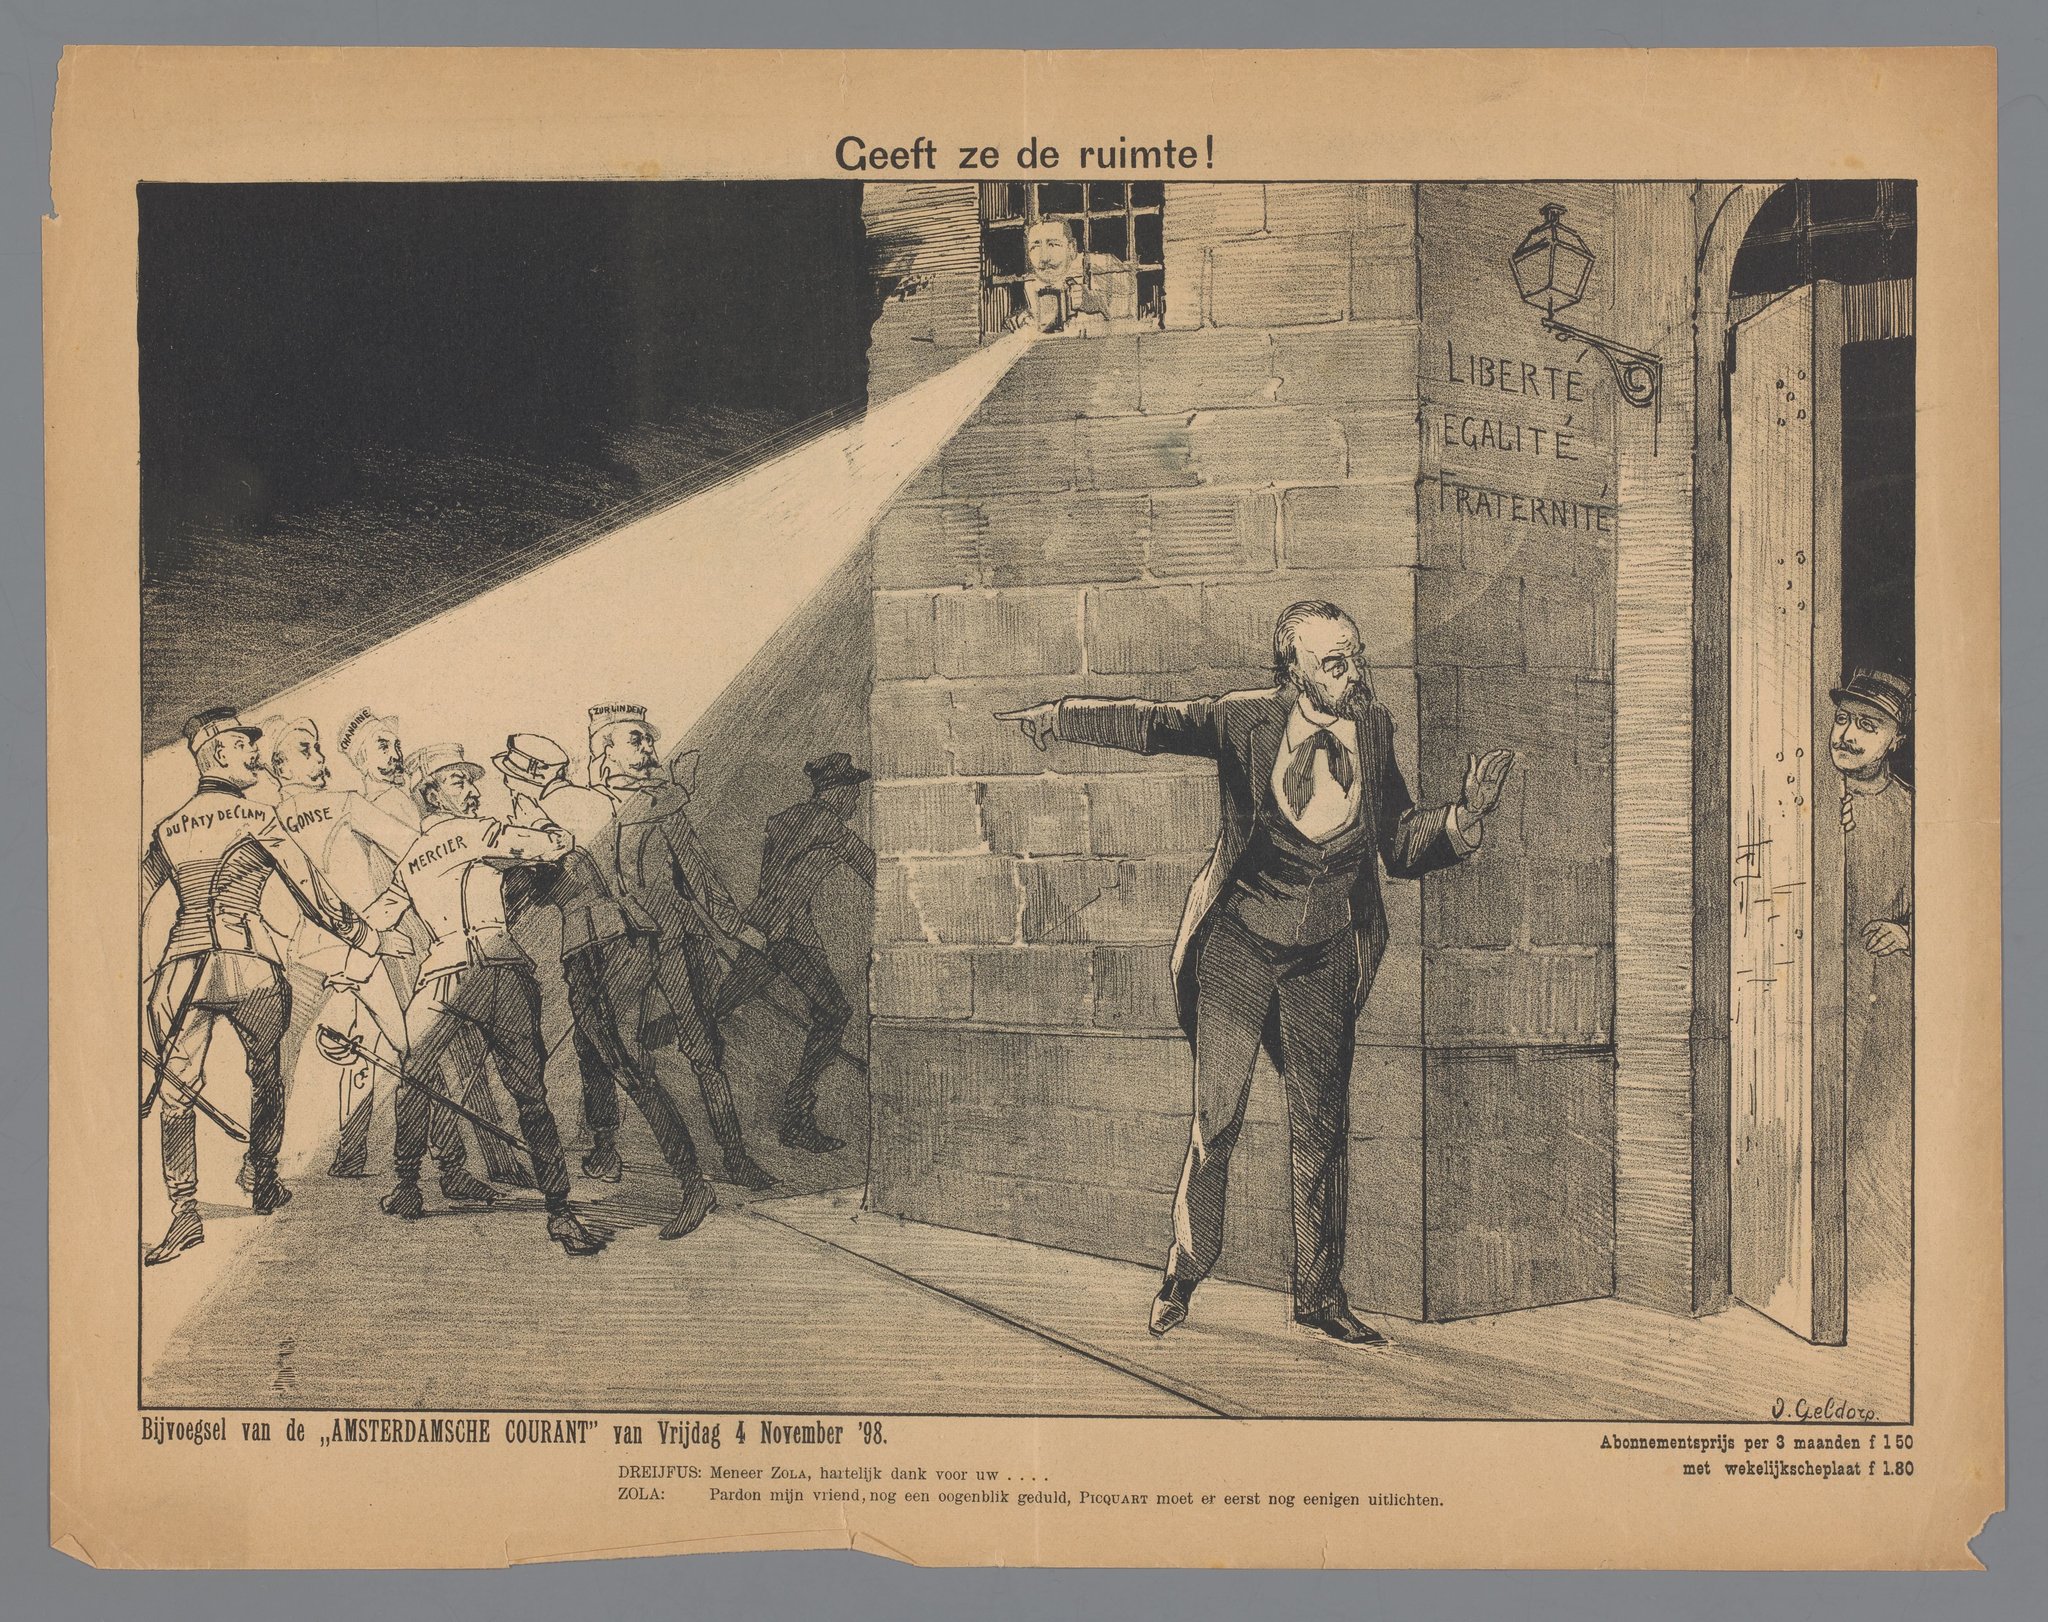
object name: cartoon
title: Geeft ze de ruimte!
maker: petrus van geldorp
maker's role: draughtsman, print maker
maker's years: 1872-1939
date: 1898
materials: paper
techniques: lithograph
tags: paris, emile zola, georges picquart, politician, e.g. party leader, political caricatures and satires, france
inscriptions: date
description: Prent uit het bijvoegsel van: De Amsterdamsche Courant, 4 november 1898.